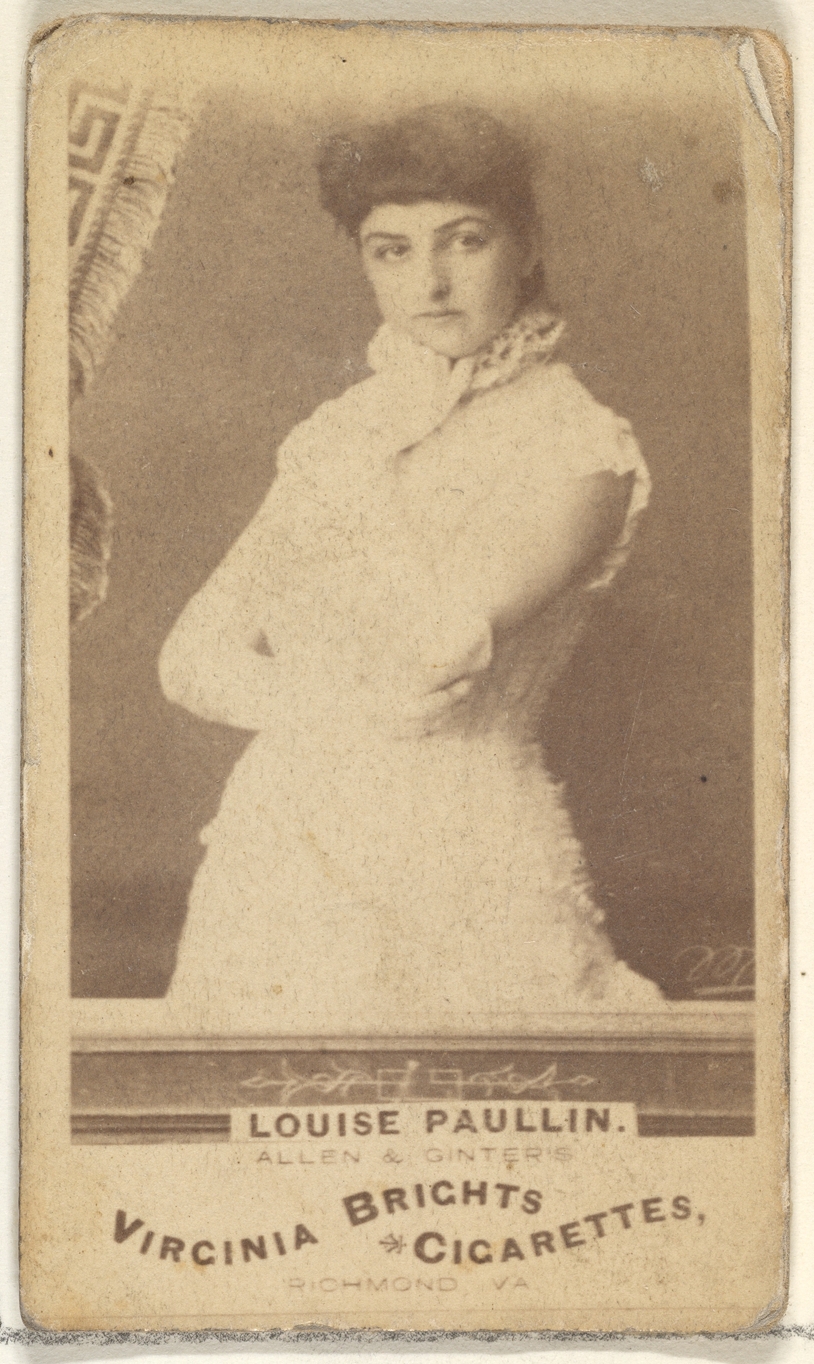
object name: photograph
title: Louise Paullin, from the Actors and Actresses series (N45, Type 1) for Virginia Brights Cigarettes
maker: allen & ginter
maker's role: publisher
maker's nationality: american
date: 1888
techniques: albumen silver print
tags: portraits,women,actresses